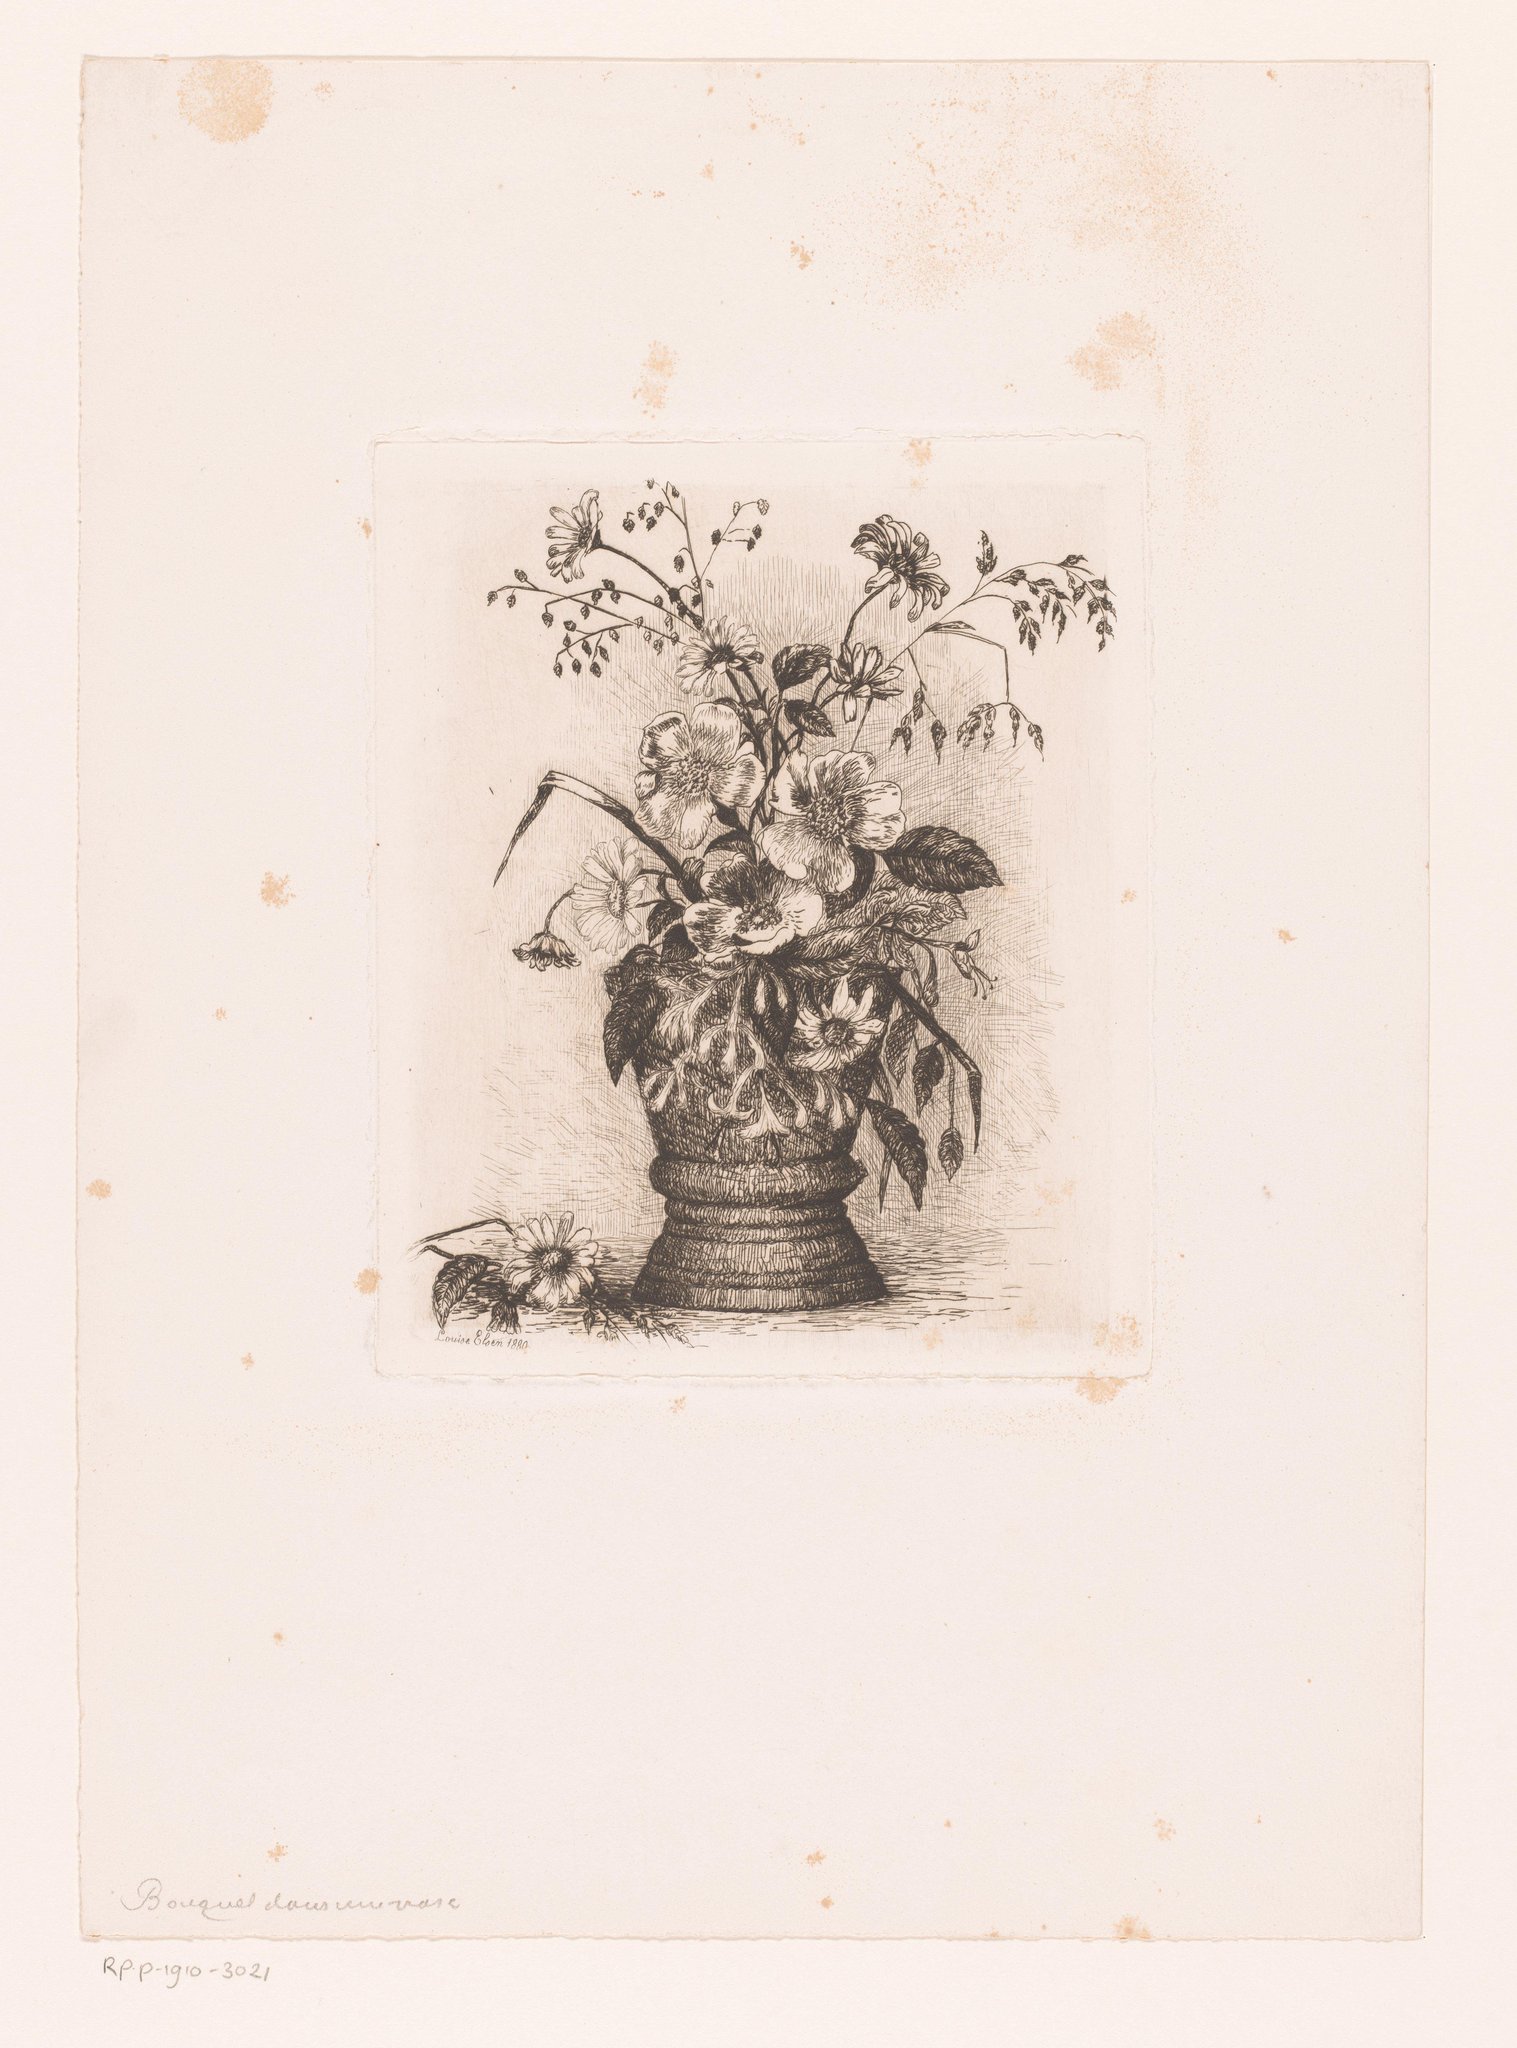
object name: print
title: Bloemen in een vaas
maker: louise elsen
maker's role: print maker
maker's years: 1853-1937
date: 1880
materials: paper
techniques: etching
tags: flowers, flowers in a vase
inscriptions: collector's mark: Lugt 2228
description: Diverse bloemen in een vaas. Links naast de vaas ligt nog een bloem.